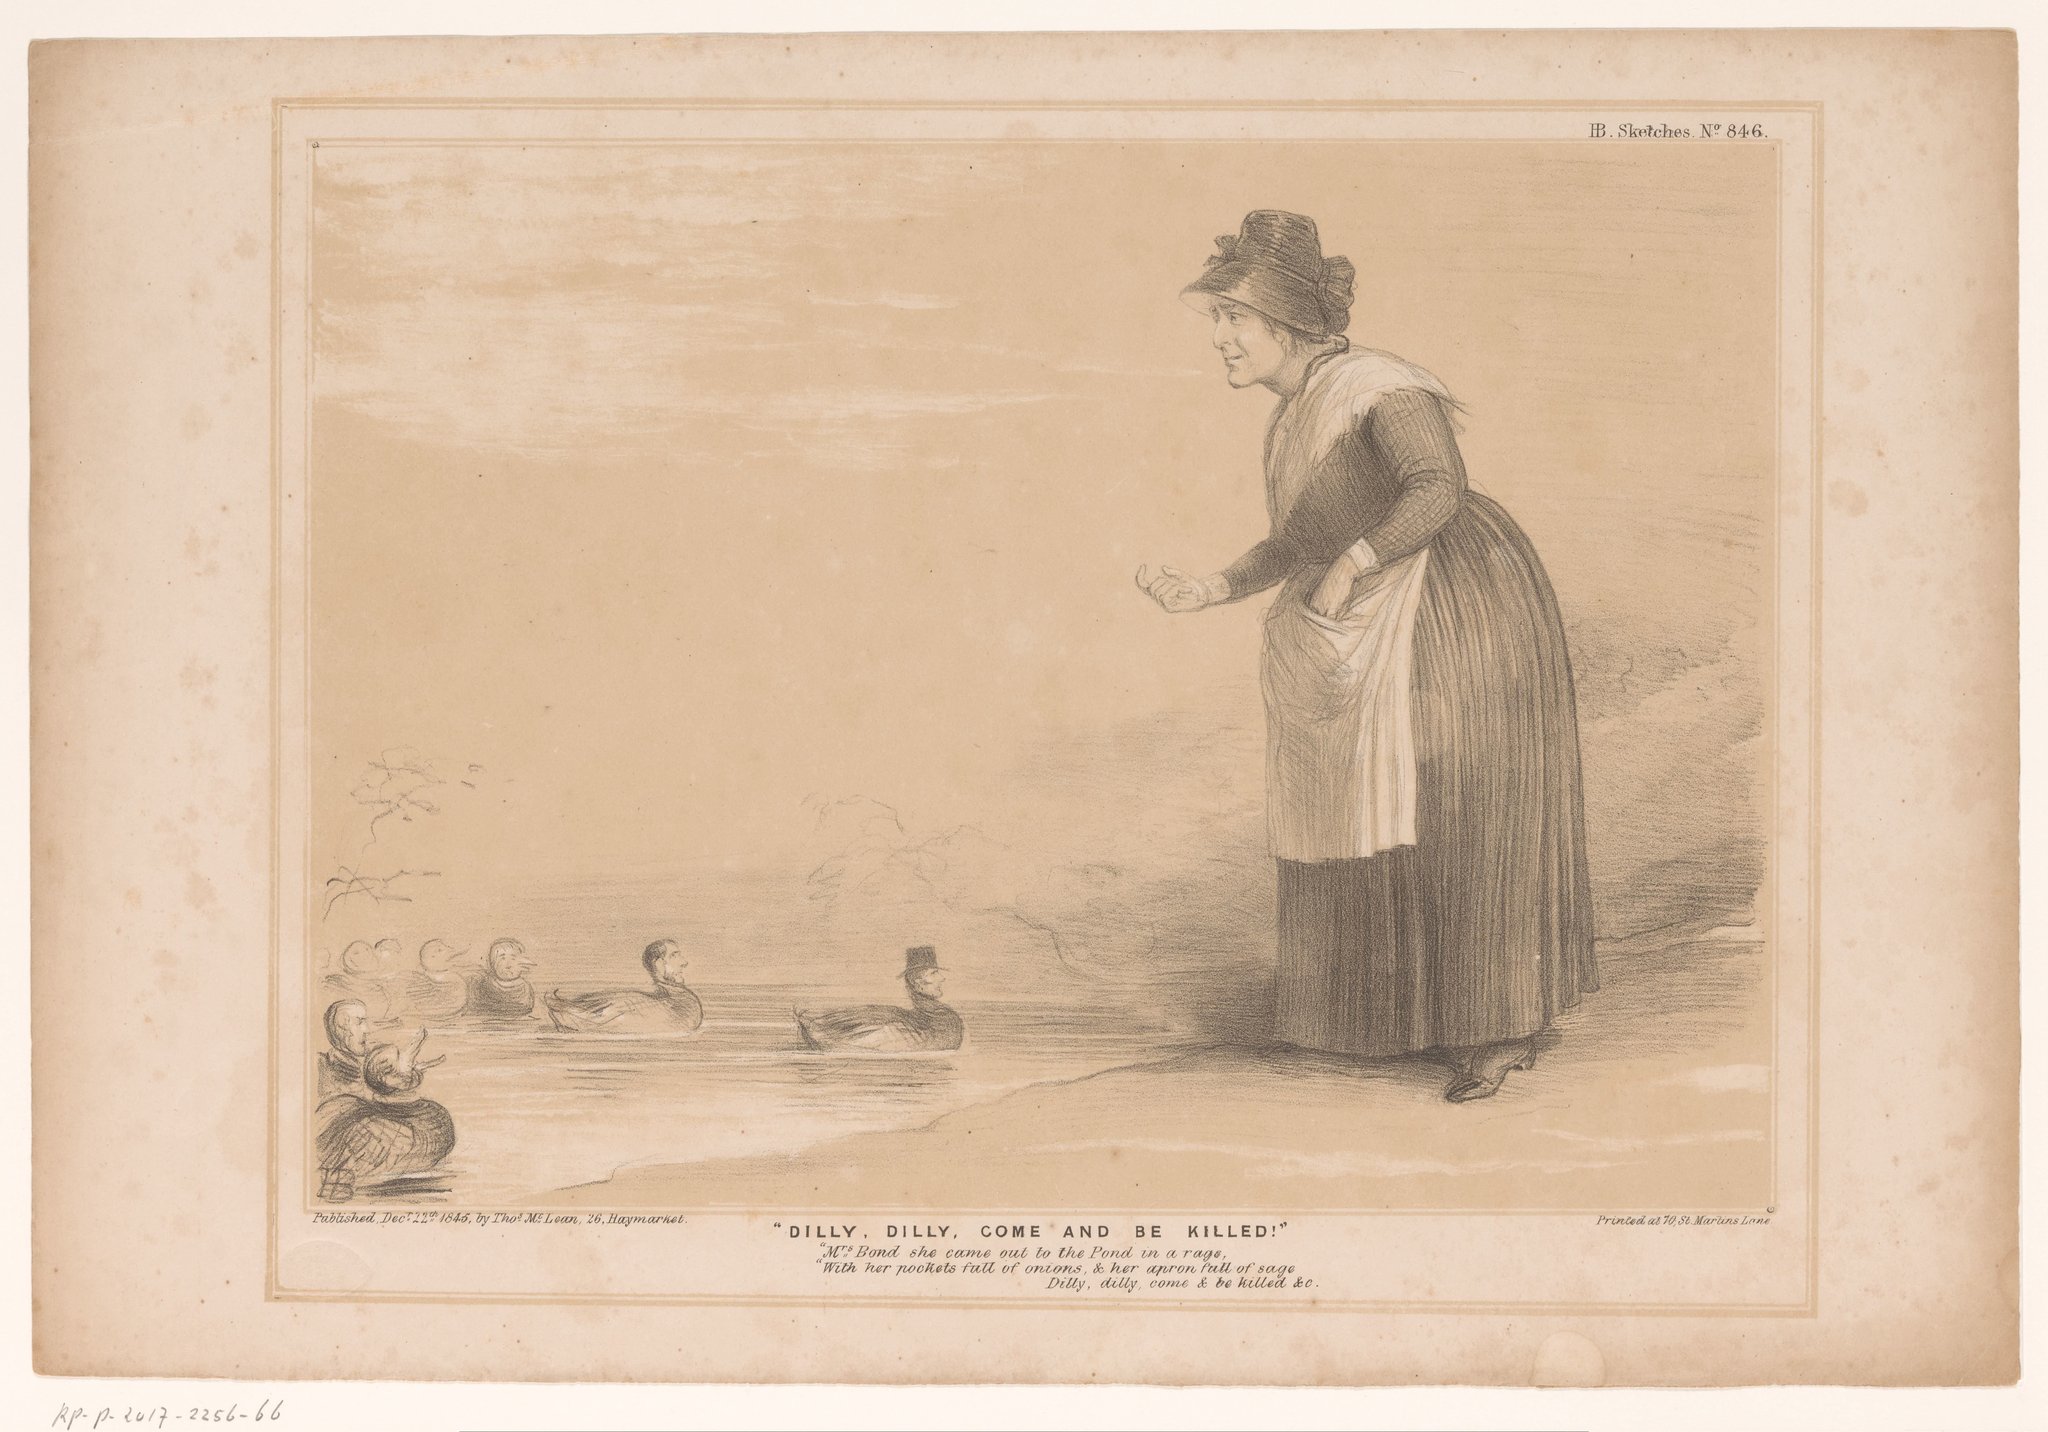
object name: cartoon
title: "Dilly, dilly, come and be killed!"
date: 1845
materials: paper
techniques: tone lithography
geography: england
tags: london, water-birds: duck, political caricatures and satires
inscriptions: stamp: ‘HB Subscribers Copy’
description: Spotprent uit 1845 met premier Robert Peel als boerin die eenden lokt om te vullen en te braden. Met enkele regels uit het Engelse kinderversje. Uitgegeven als nr. 846 in de serie HB Sketches.